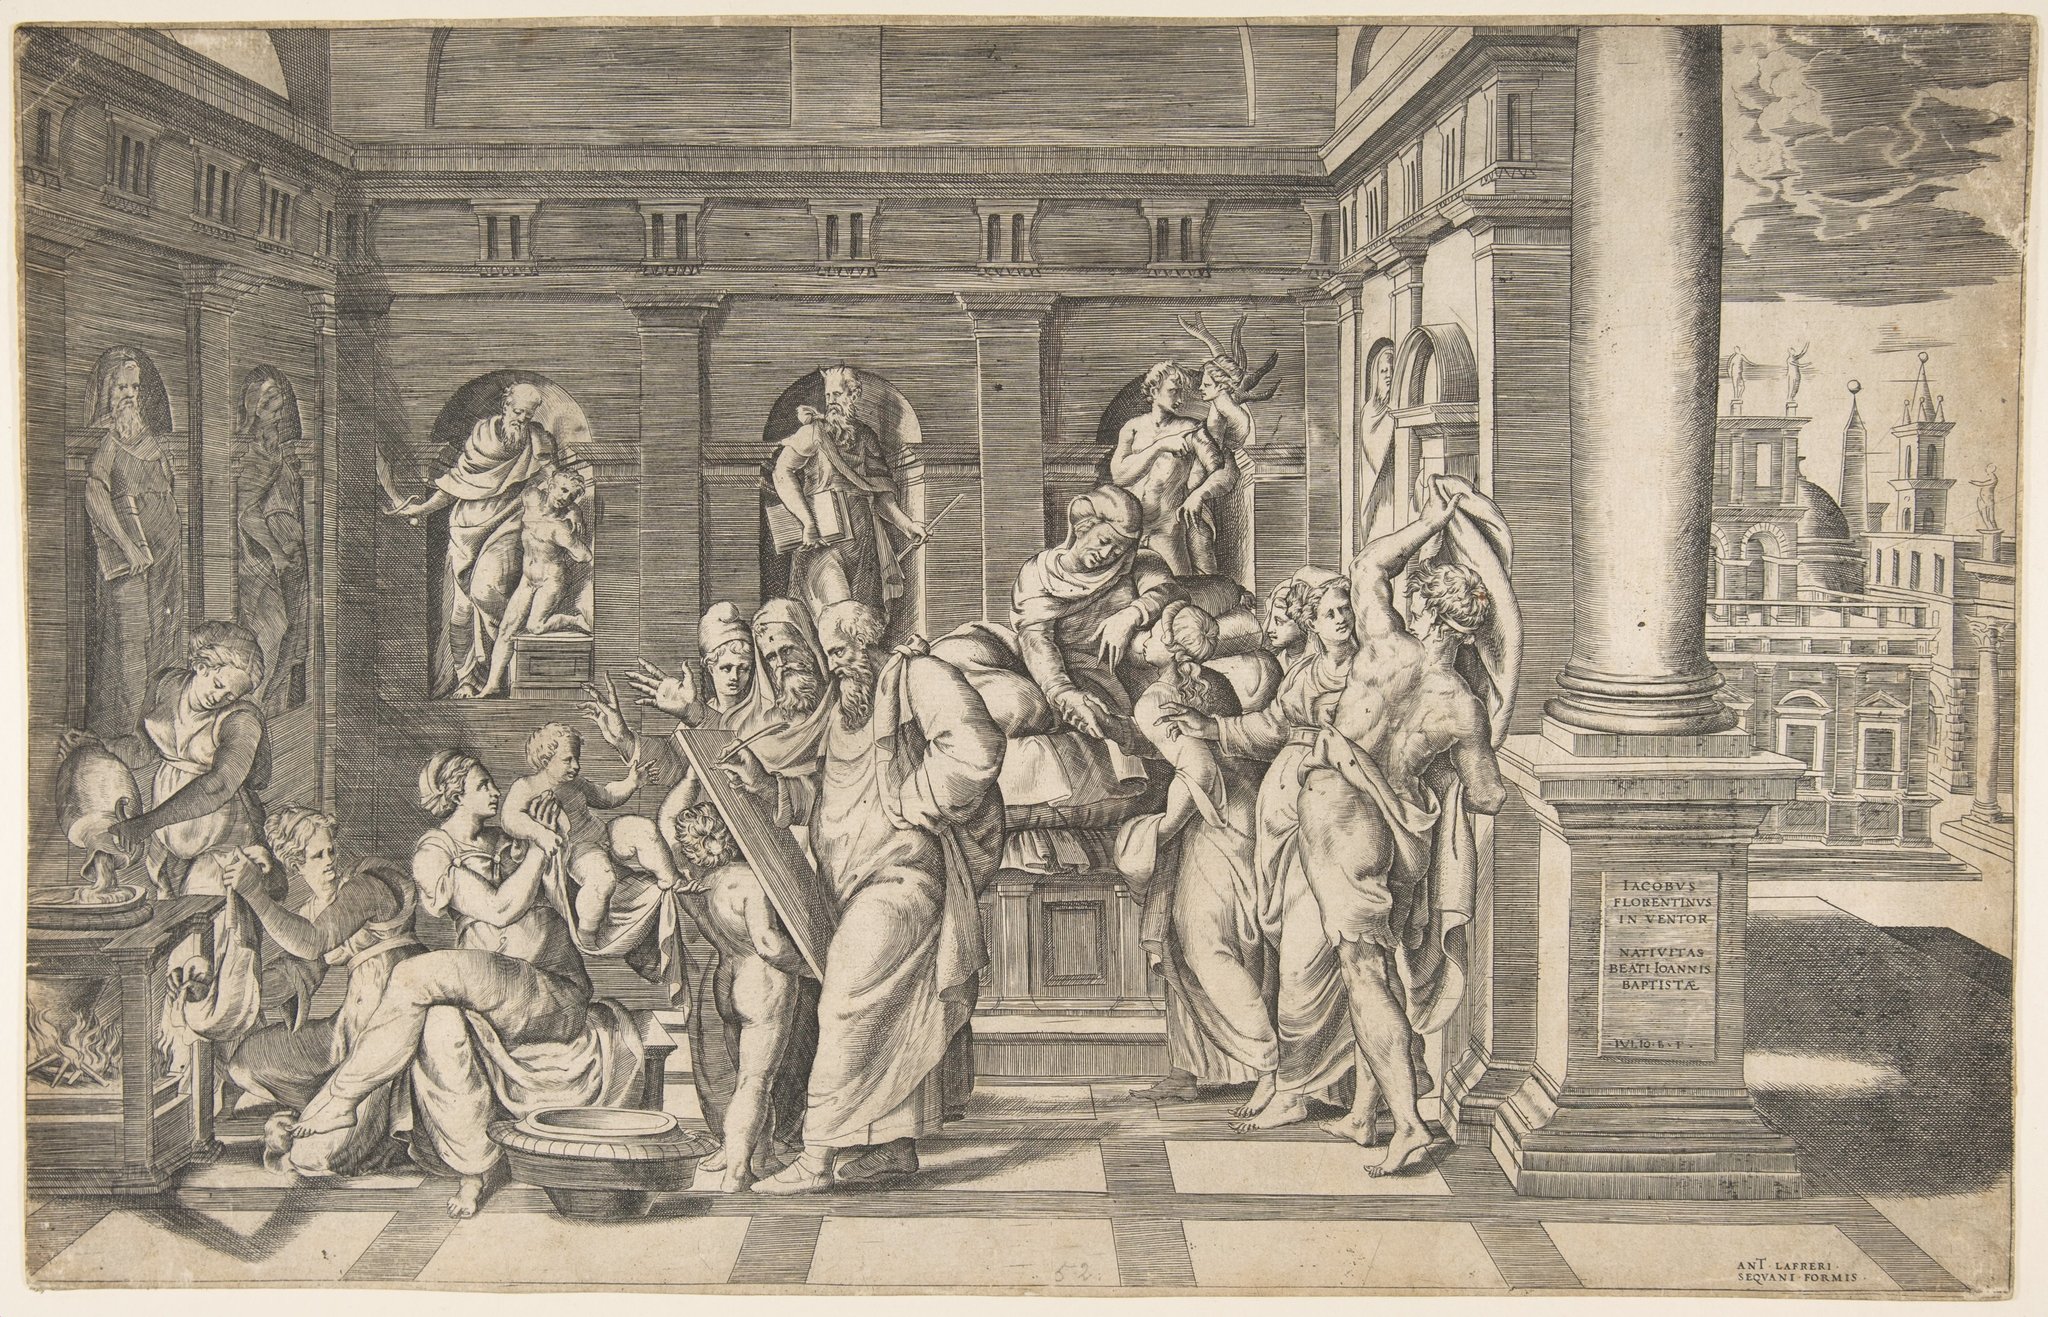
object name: print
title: The birth of Saint John the Baptist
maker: giulio bonasone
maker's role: artist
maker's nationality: italian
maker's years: 1510-1576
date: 1538-1545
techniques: engraving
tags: men,women,saint john the baptist,birth